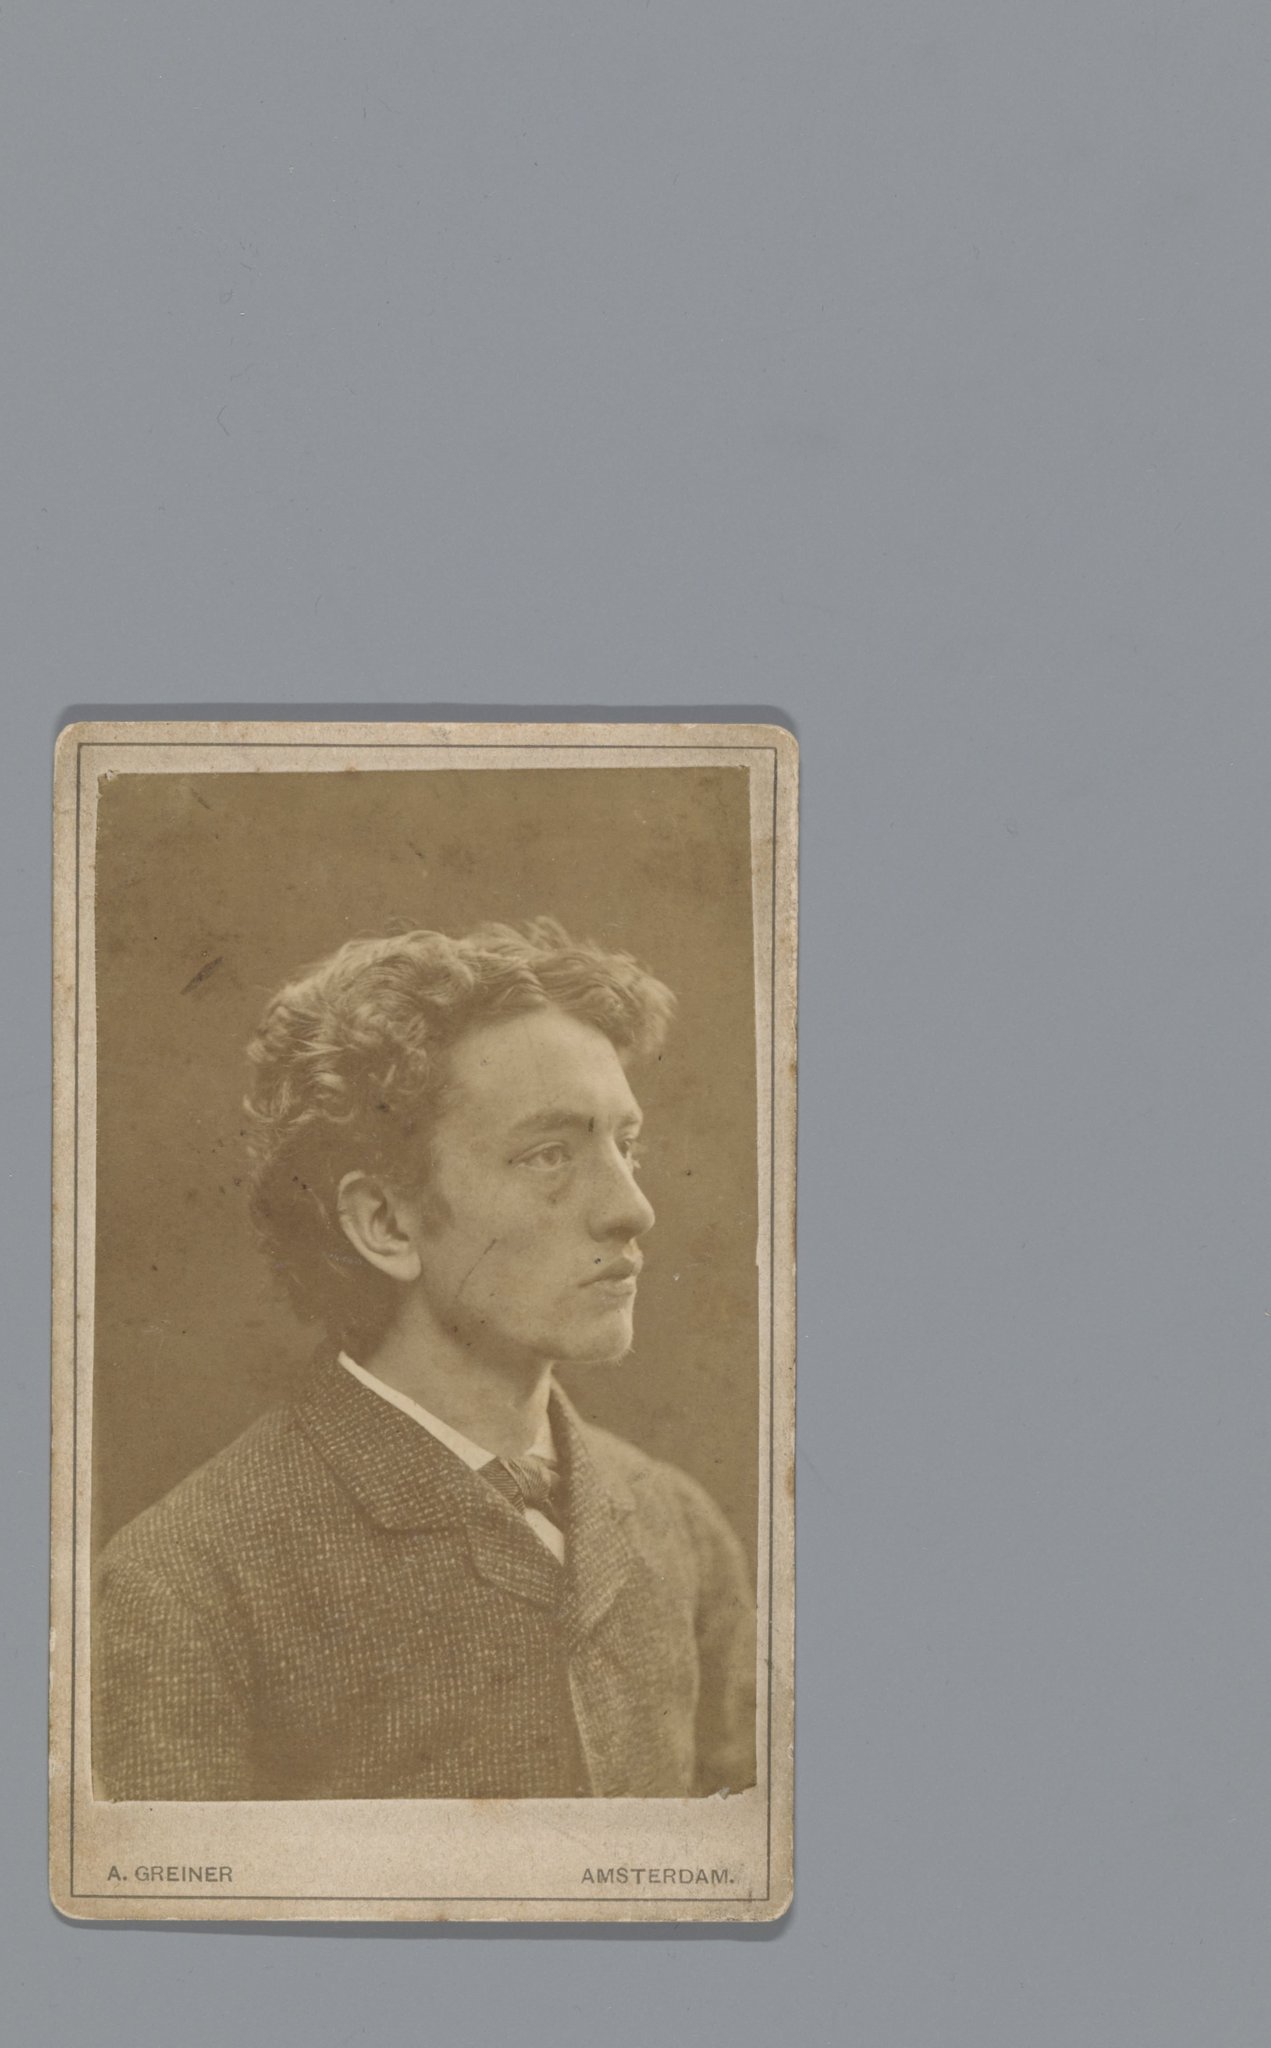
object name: photograph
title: Karel Witsen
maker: albert greiner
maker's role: fotograaf, fotostudio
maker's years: 1833-1890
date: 1860-1915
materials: paper, photographic support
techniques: albumen print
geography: netherlands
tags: karel witsen